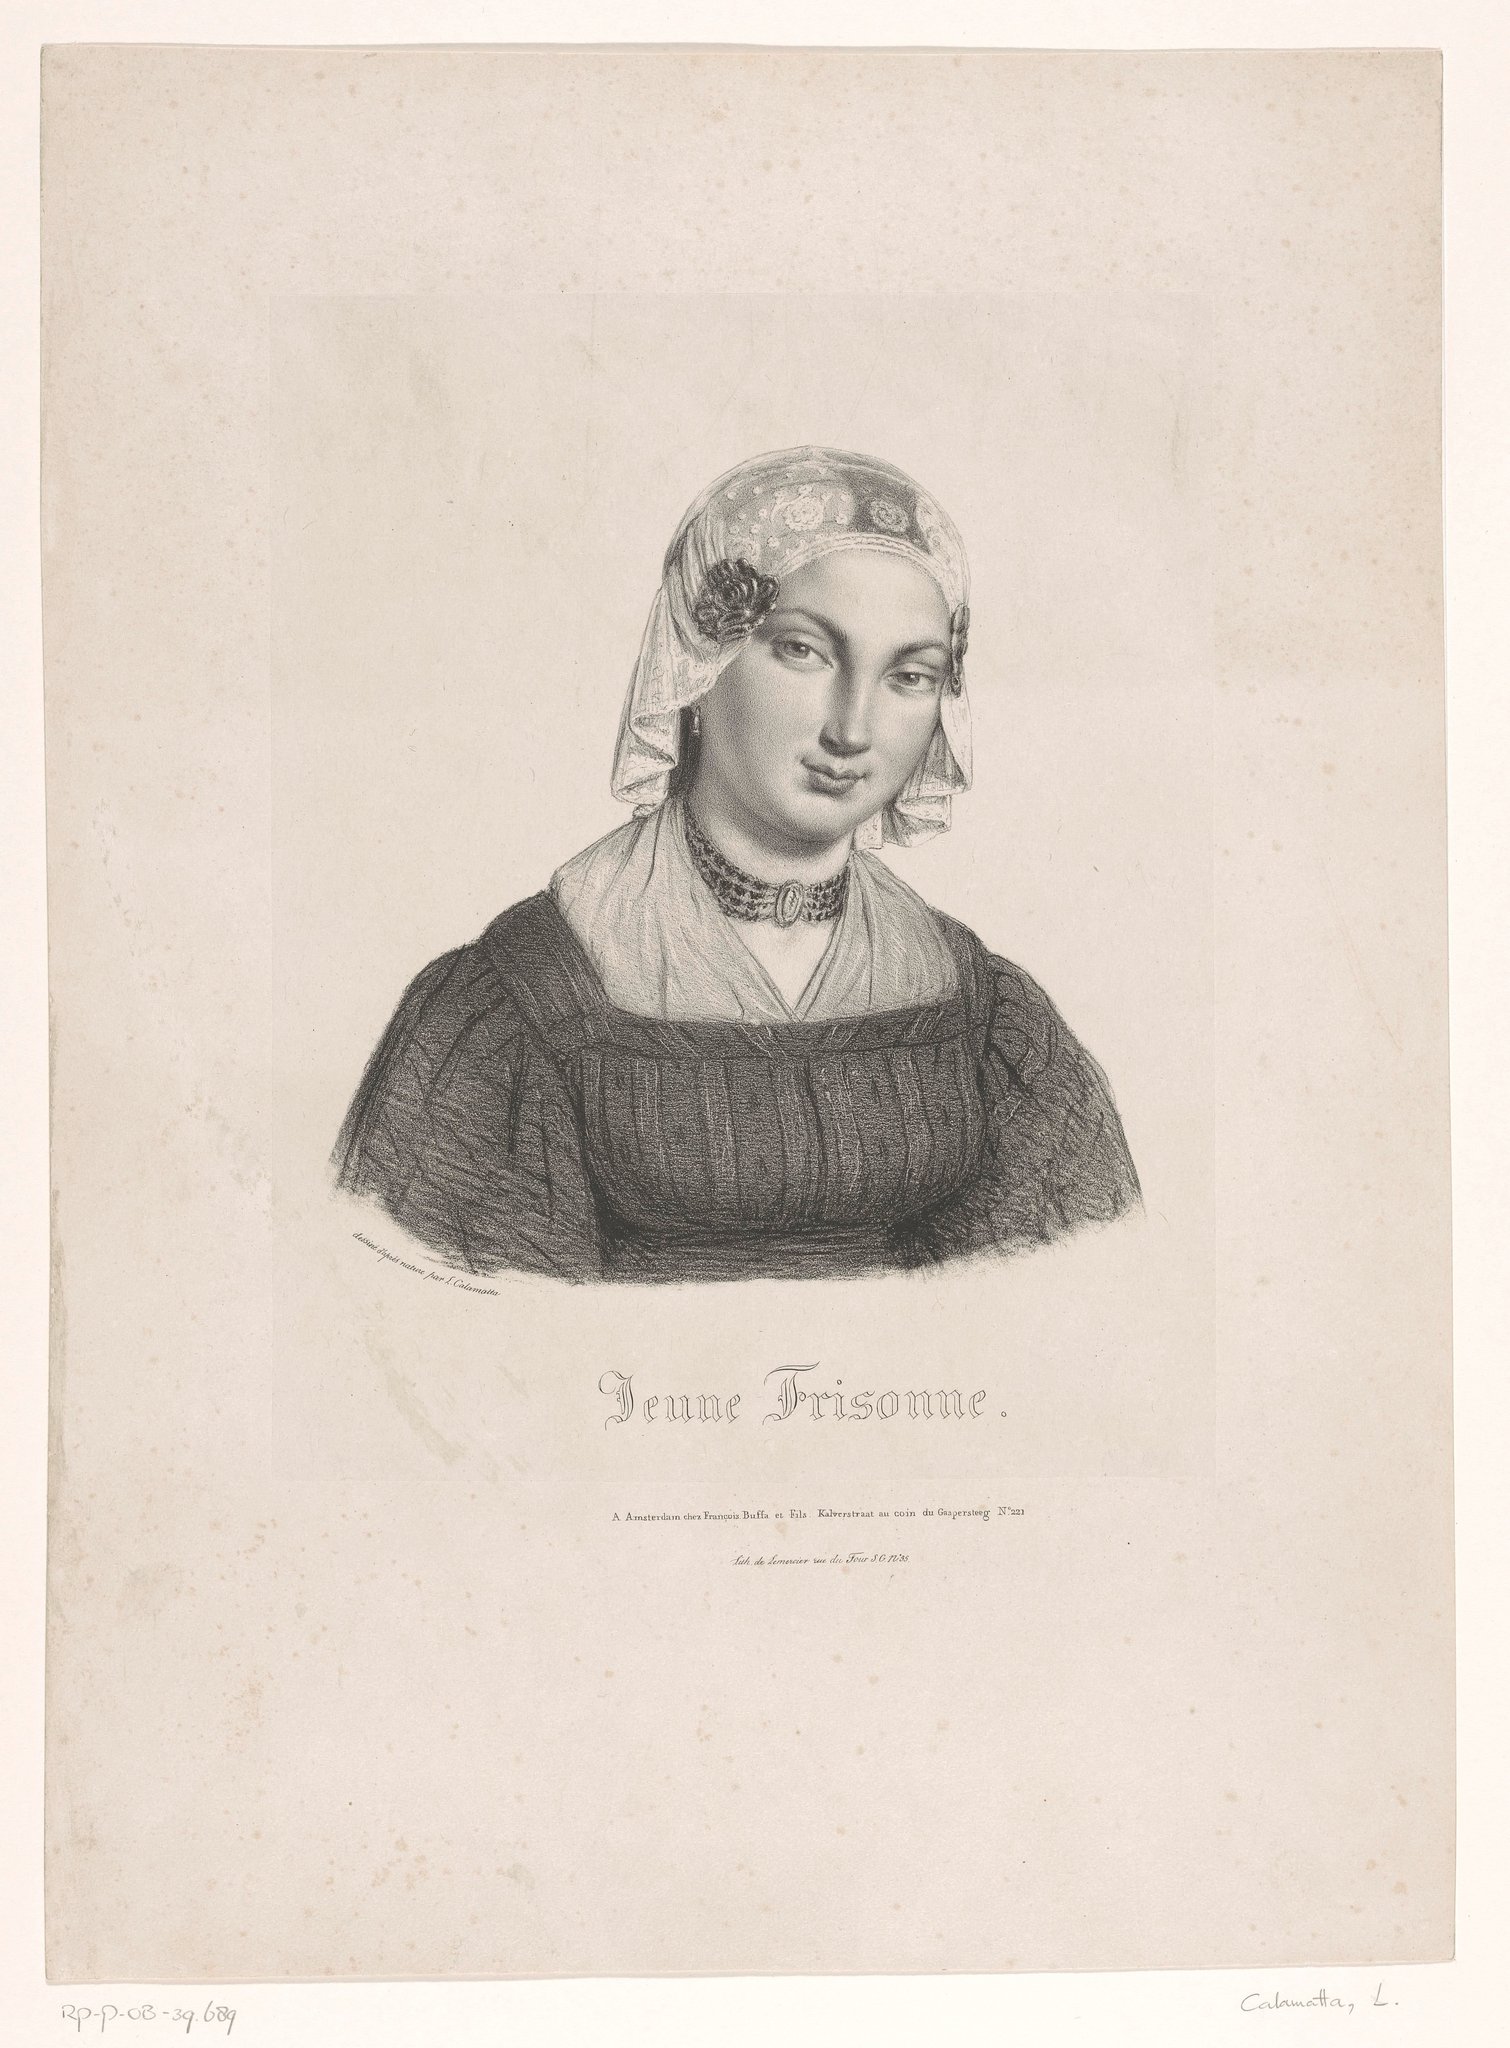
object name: print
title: Jonge Friezin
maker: joseph rose lemercier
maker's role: printer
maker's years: 1803-1887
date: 1811-1869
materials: paper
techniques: lithograph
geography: paris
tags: anonymous historical person portrayed - bb - woman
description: Buste van een jonge vrouw in klederdracht. Titel onder voorstelling in het Frans.